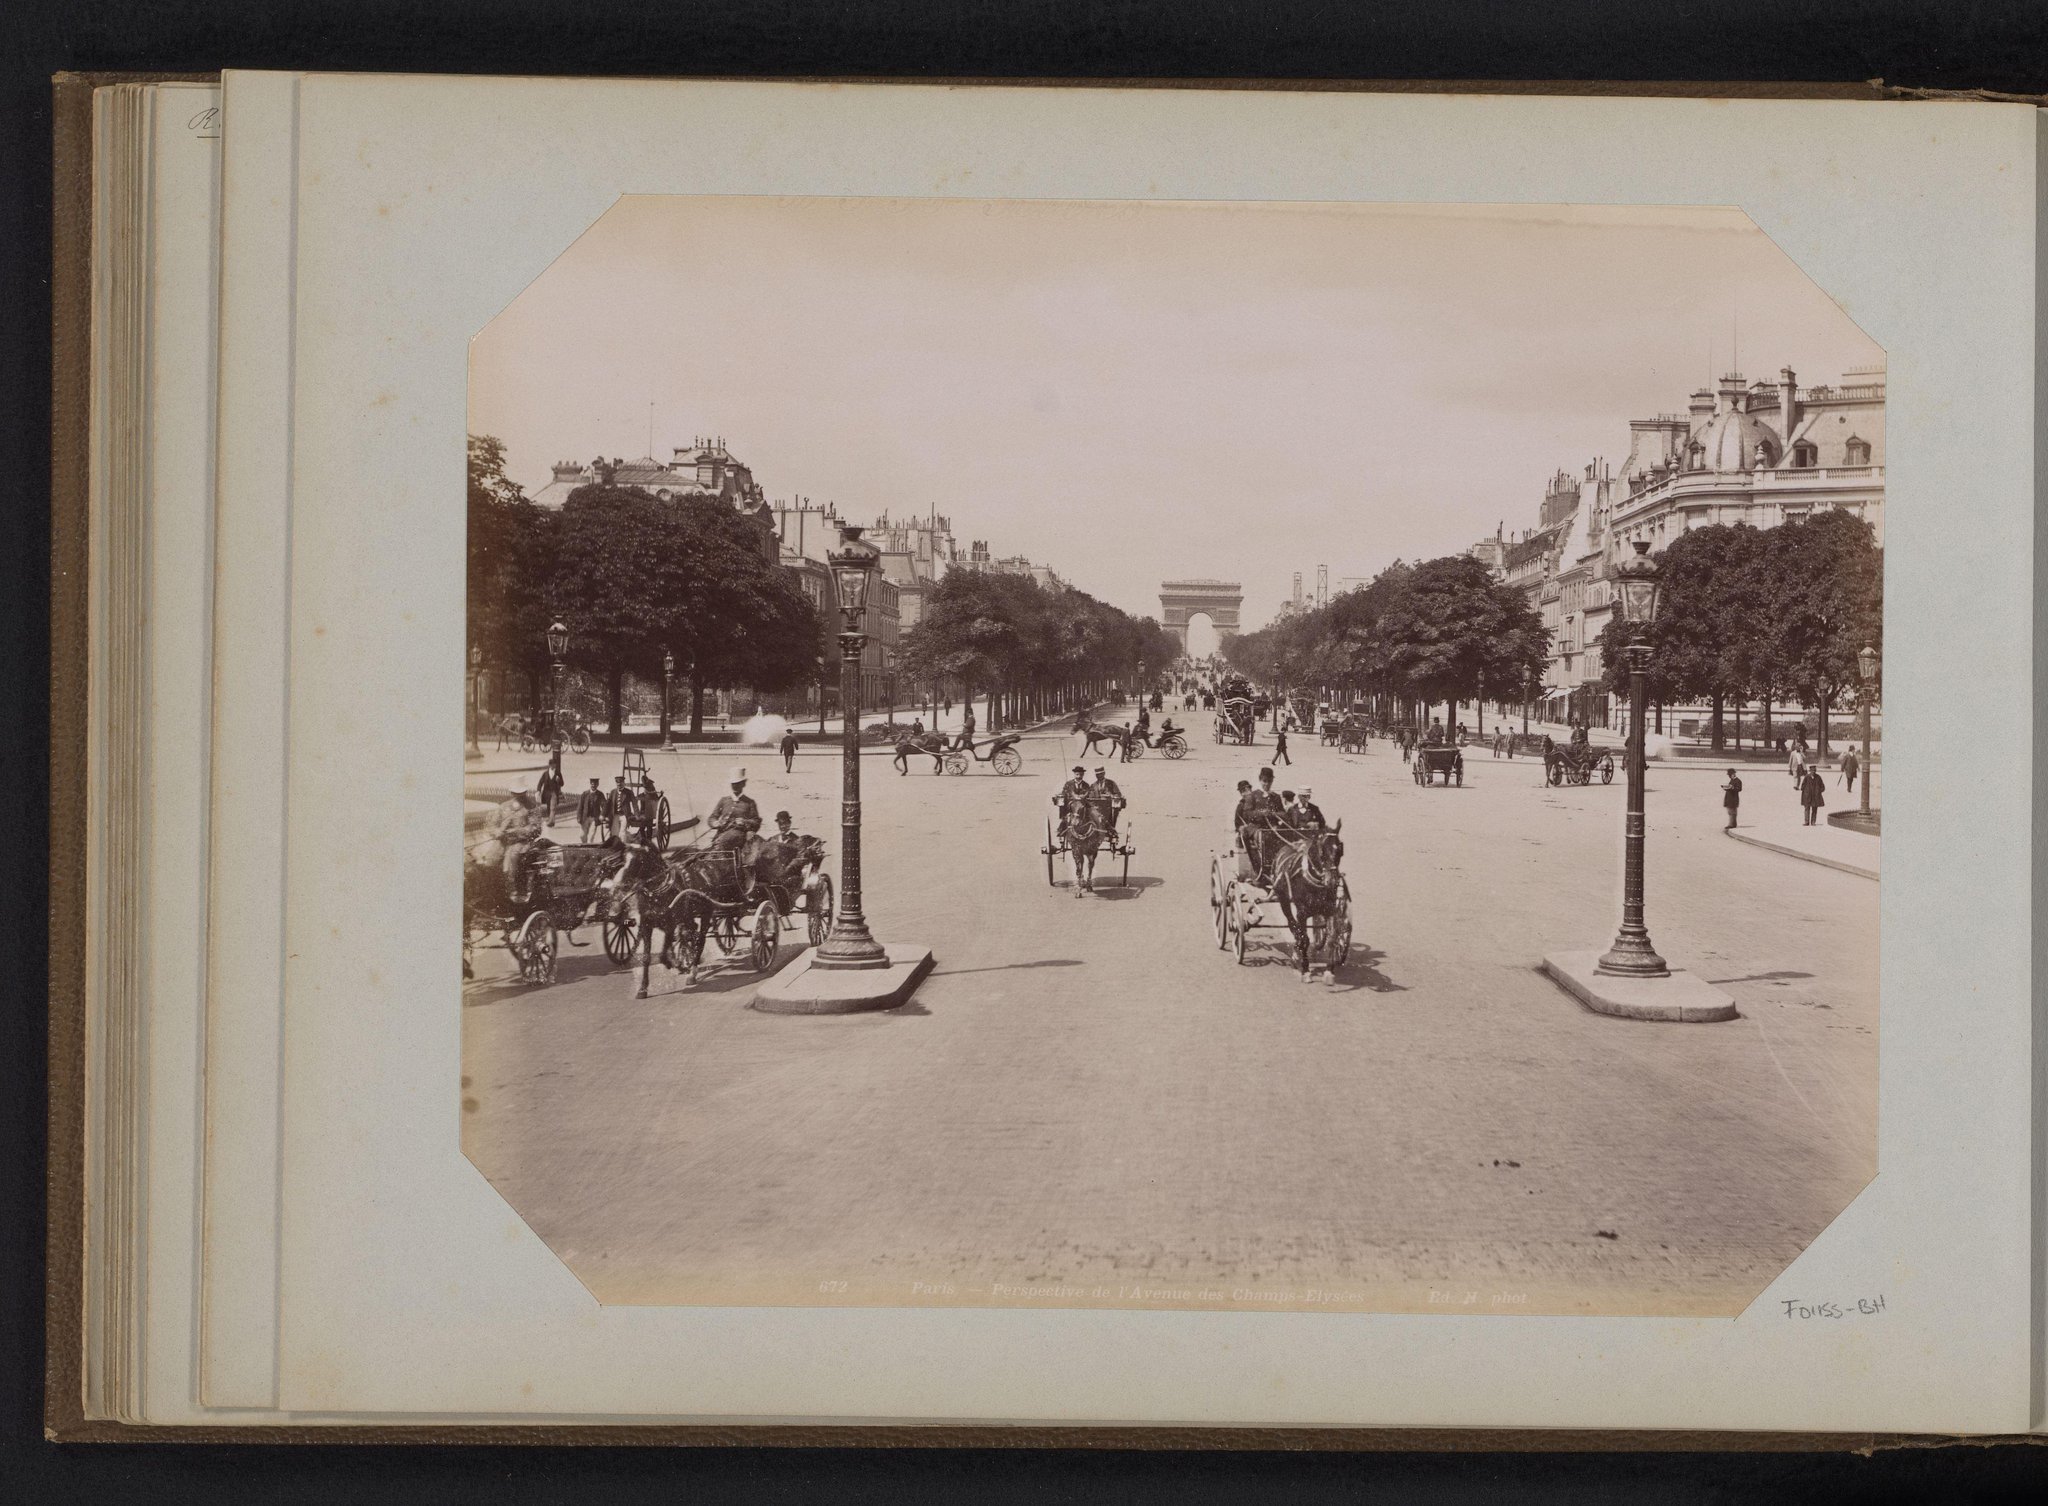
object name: album leaf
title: Gezicht op de Champs-Élysées met de Arc de Triomphe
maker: edouard hautecoer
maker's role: publisher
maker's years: 1847-1904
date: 1890-1898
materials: photographic support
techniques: albumen print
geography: paris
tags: avenue, boulevard, promenade, esplanade (+ city(-scape) with figures, staffage)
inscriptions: inscription: ‘672 Paris - Perspective de l'Avenue des Champs-Elysées. Ed. H. Phot.’, retailer's mark: ‘E. Hautecoeur/ Estampes Photographies/ 35 Avenue de l'Opéra, 35/ Paris’